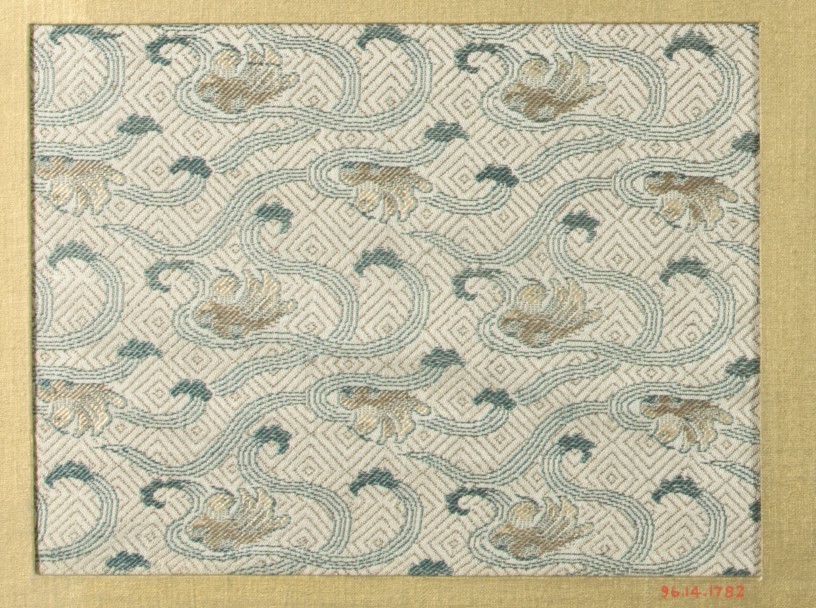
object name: piece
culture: japanese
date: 1701-1900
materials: silk